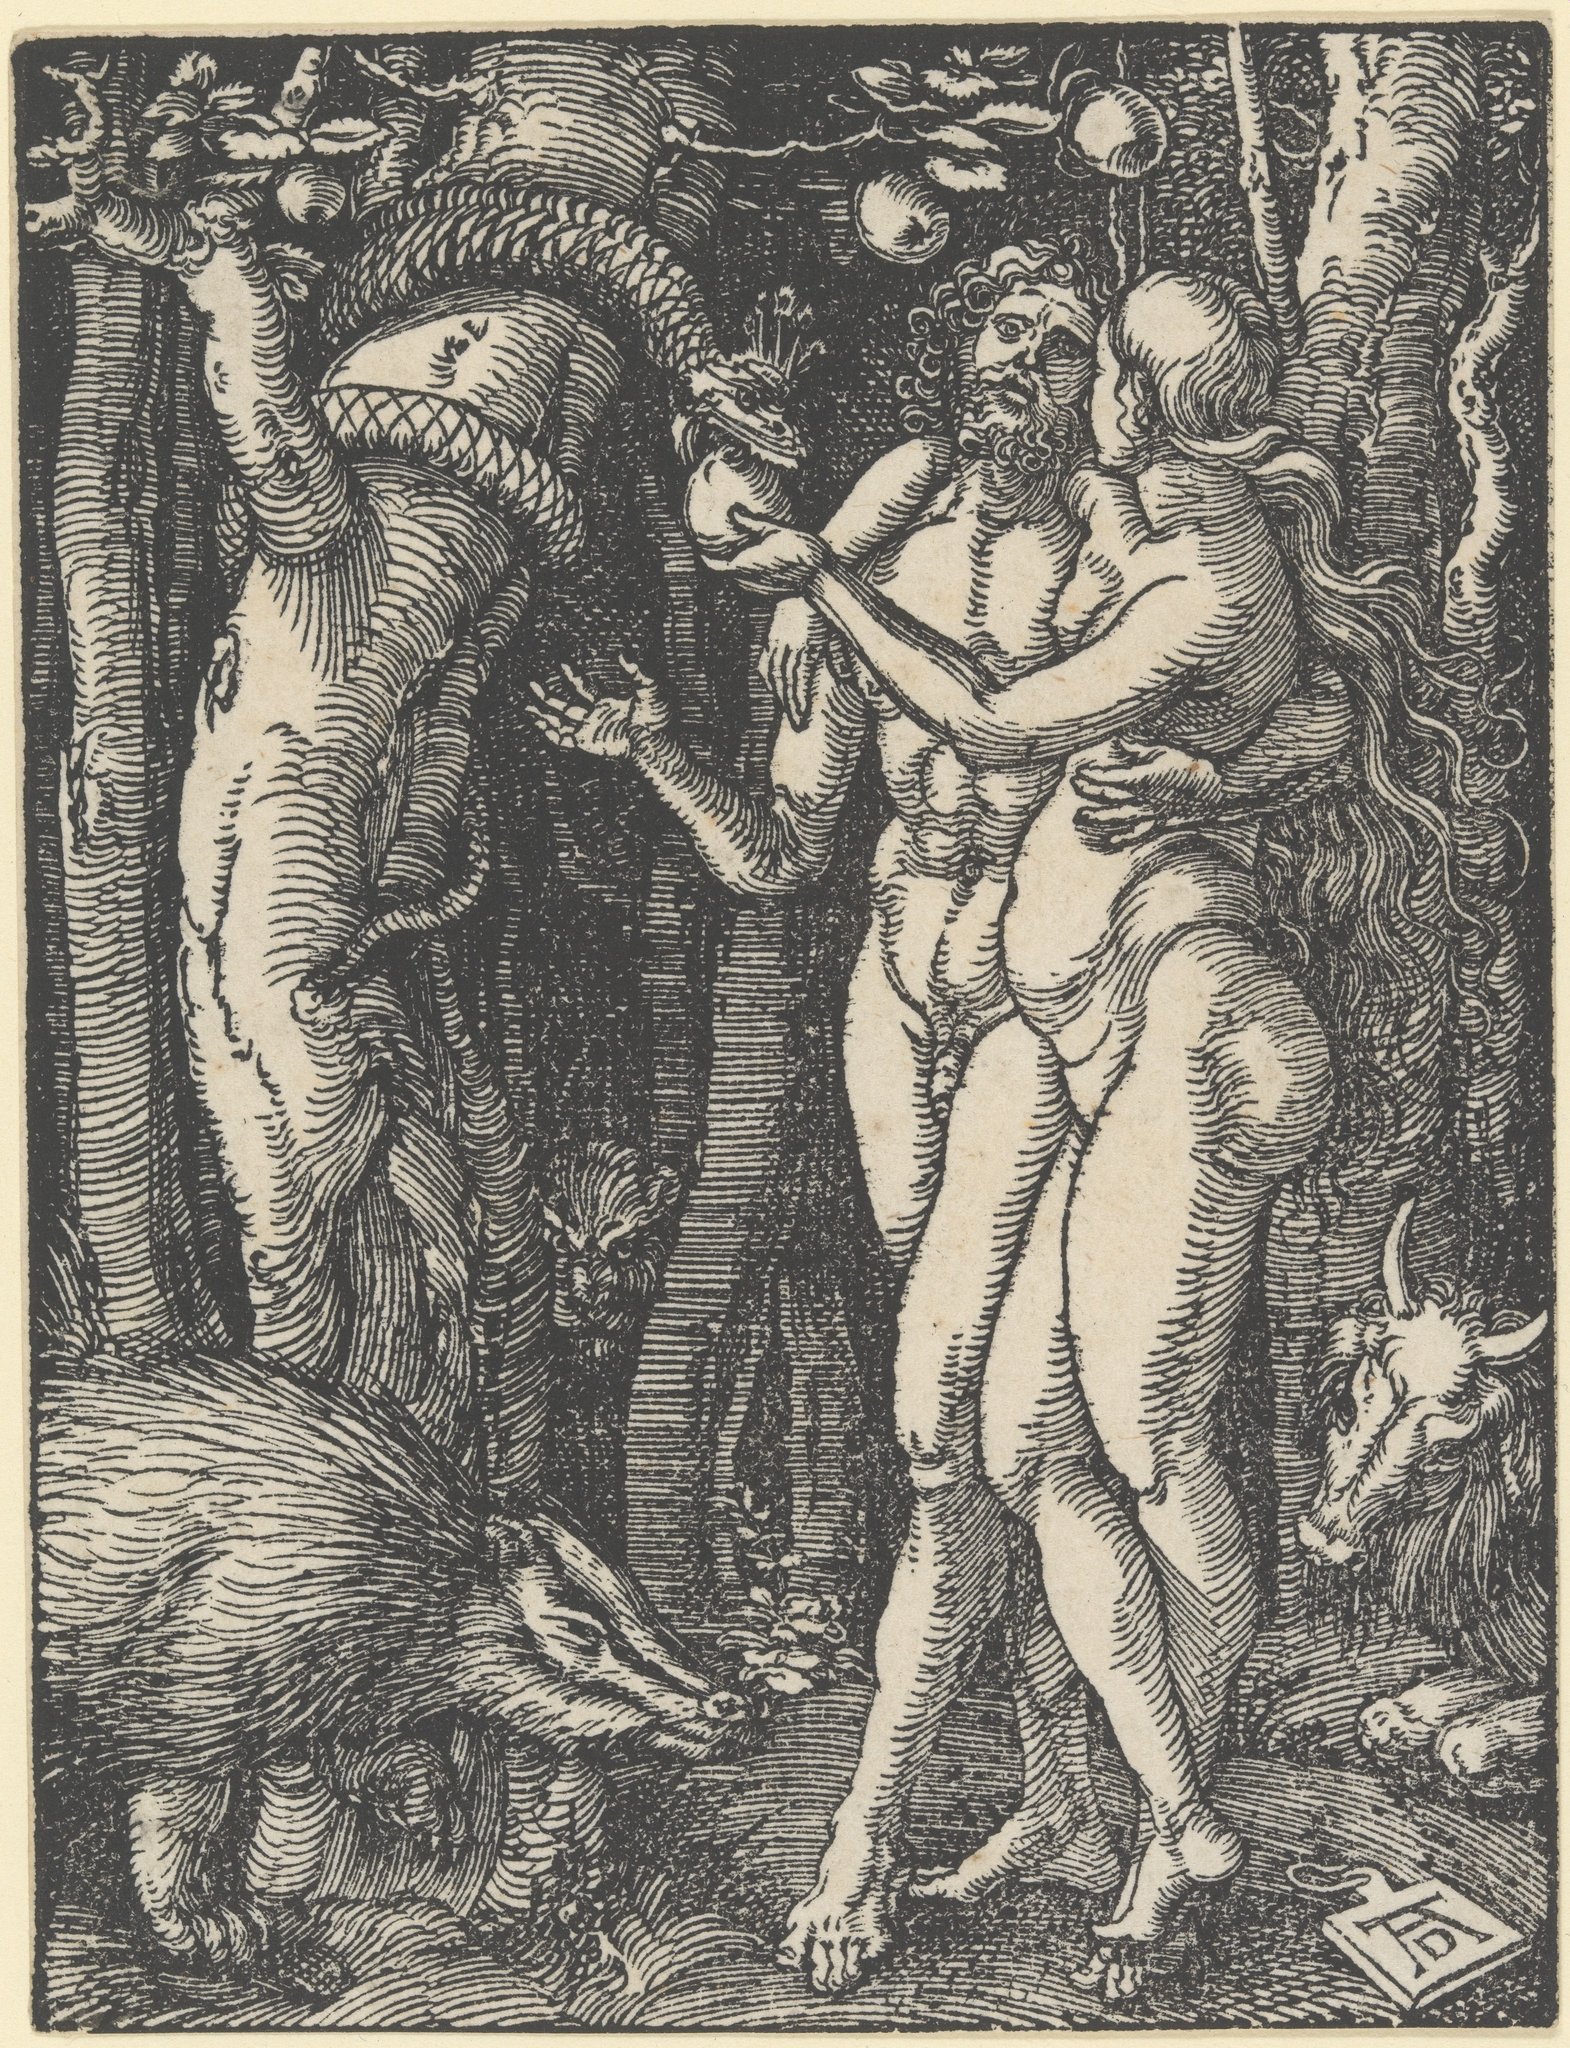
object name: print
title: The Fall of Man, from "The Small Passion"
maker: albrecht dürer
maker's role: artist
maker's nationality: german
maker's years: 1471-1528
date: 1510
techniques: woodcut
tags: adam,eve